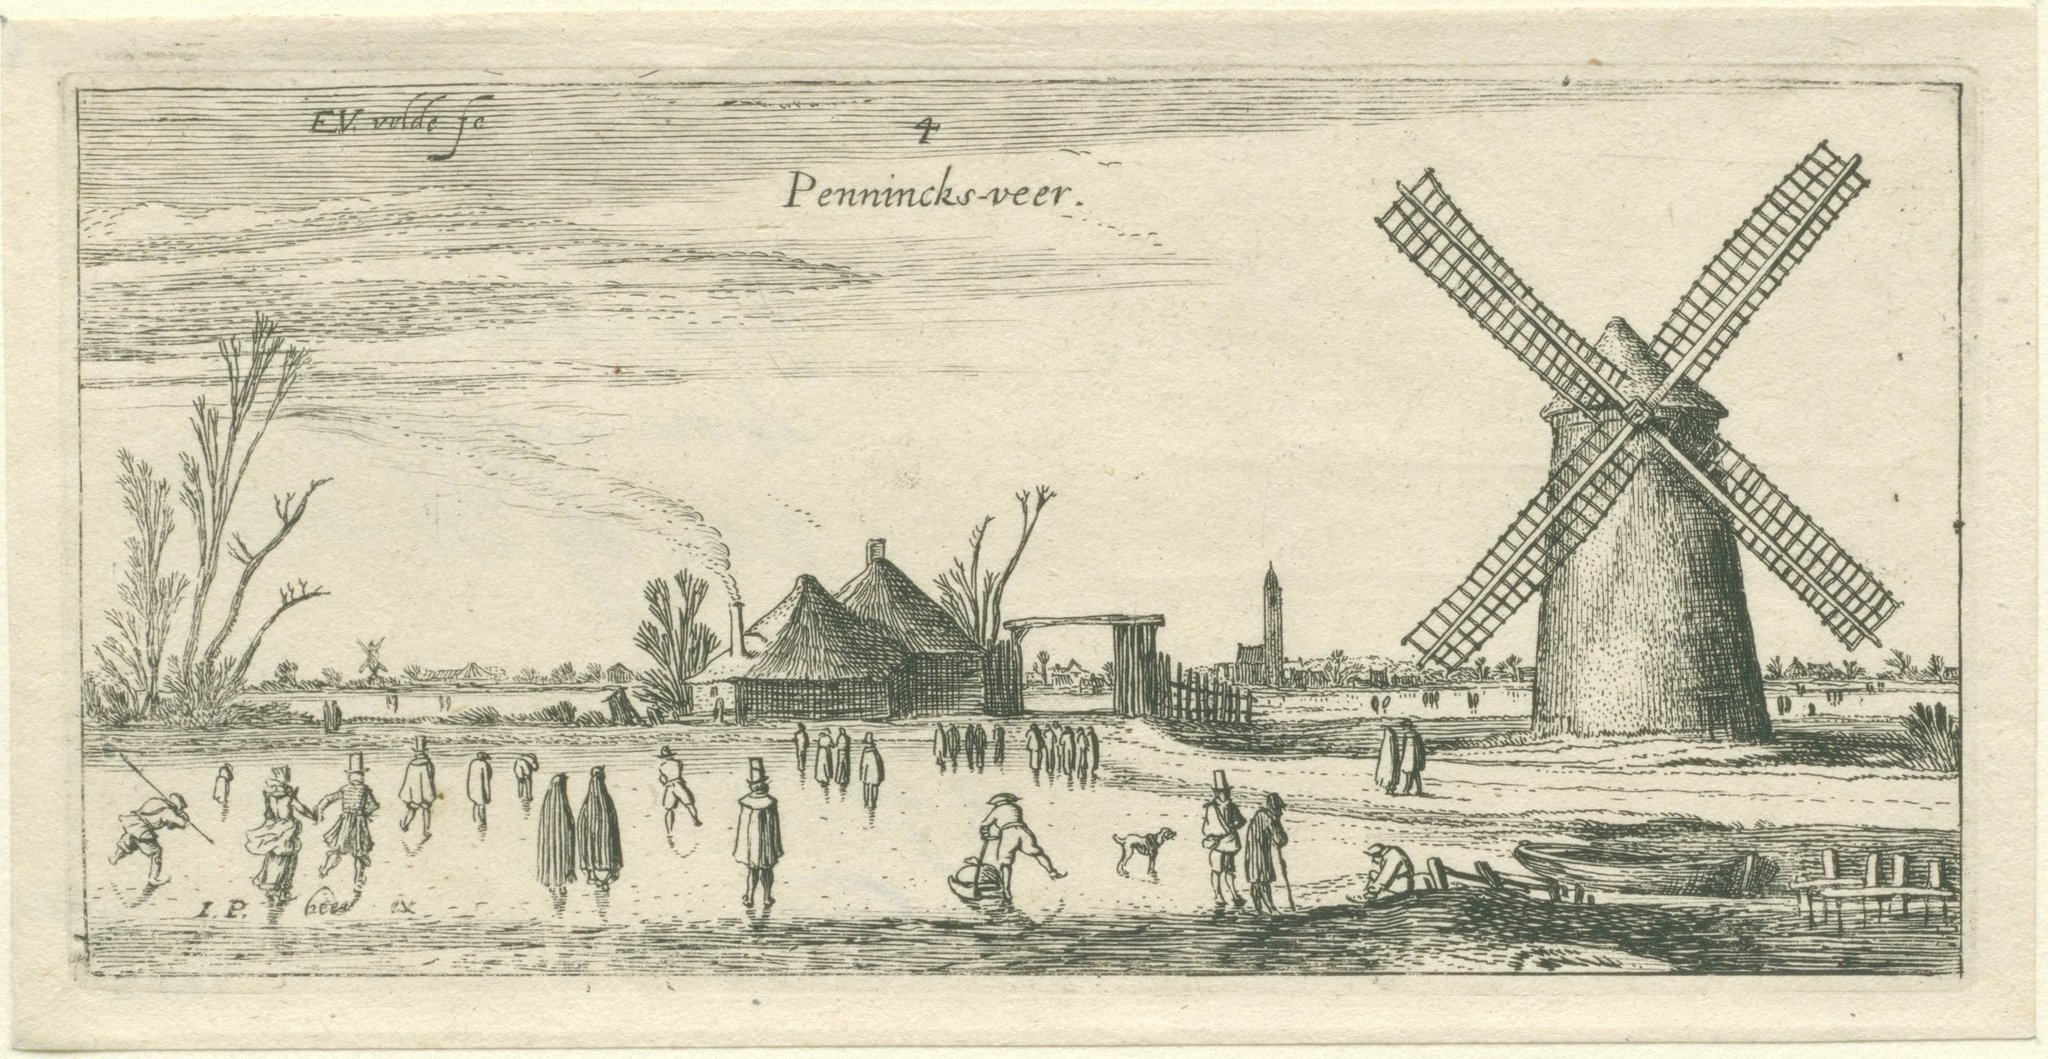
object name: print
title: Landschappen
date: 1615-1616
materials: paper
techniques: engraving, etching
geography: haarlem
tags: windmill in landscape, skates (winter sports)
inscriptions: collector's mark: Lugt 2228a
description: Boven het landschap staat de naam van het dorp dat in dit winterlandschap aan de horizon ligt: Pennincksveer